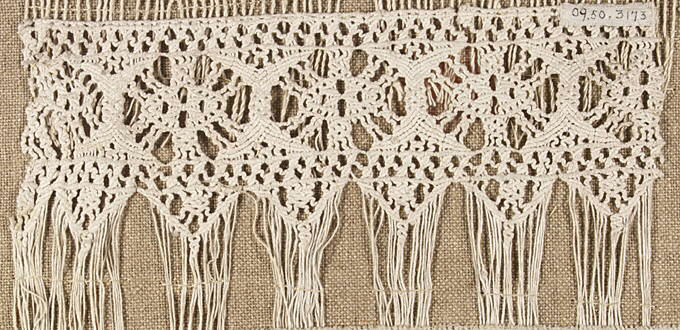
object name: fragment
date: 1701-1800